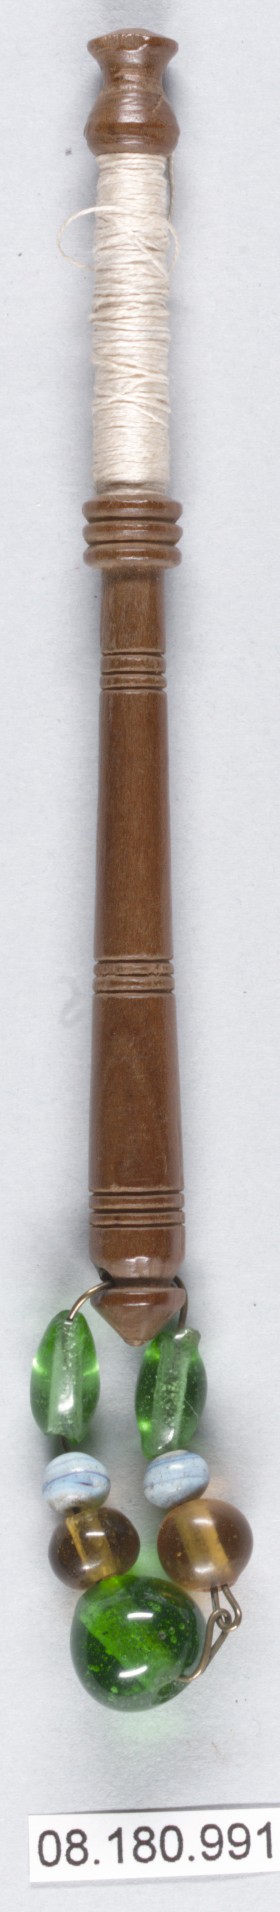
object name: bobbin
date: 1801-1900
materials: wood